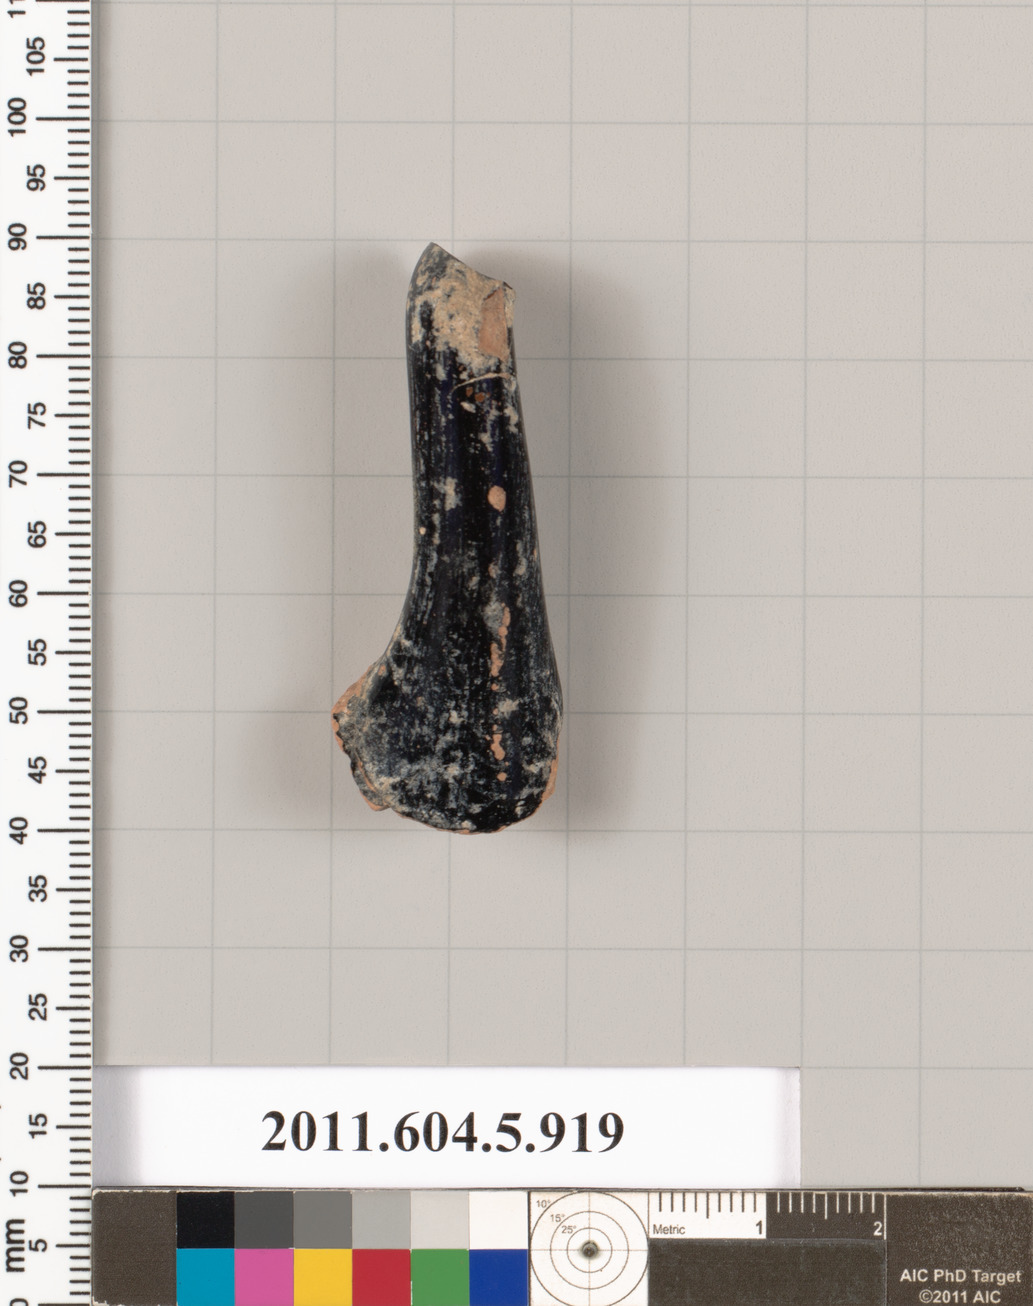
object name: kylix fragment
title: Terracotta fragment of a kylix (drinking cup)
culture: greek, attic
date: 600-401 BCE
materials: terracotta